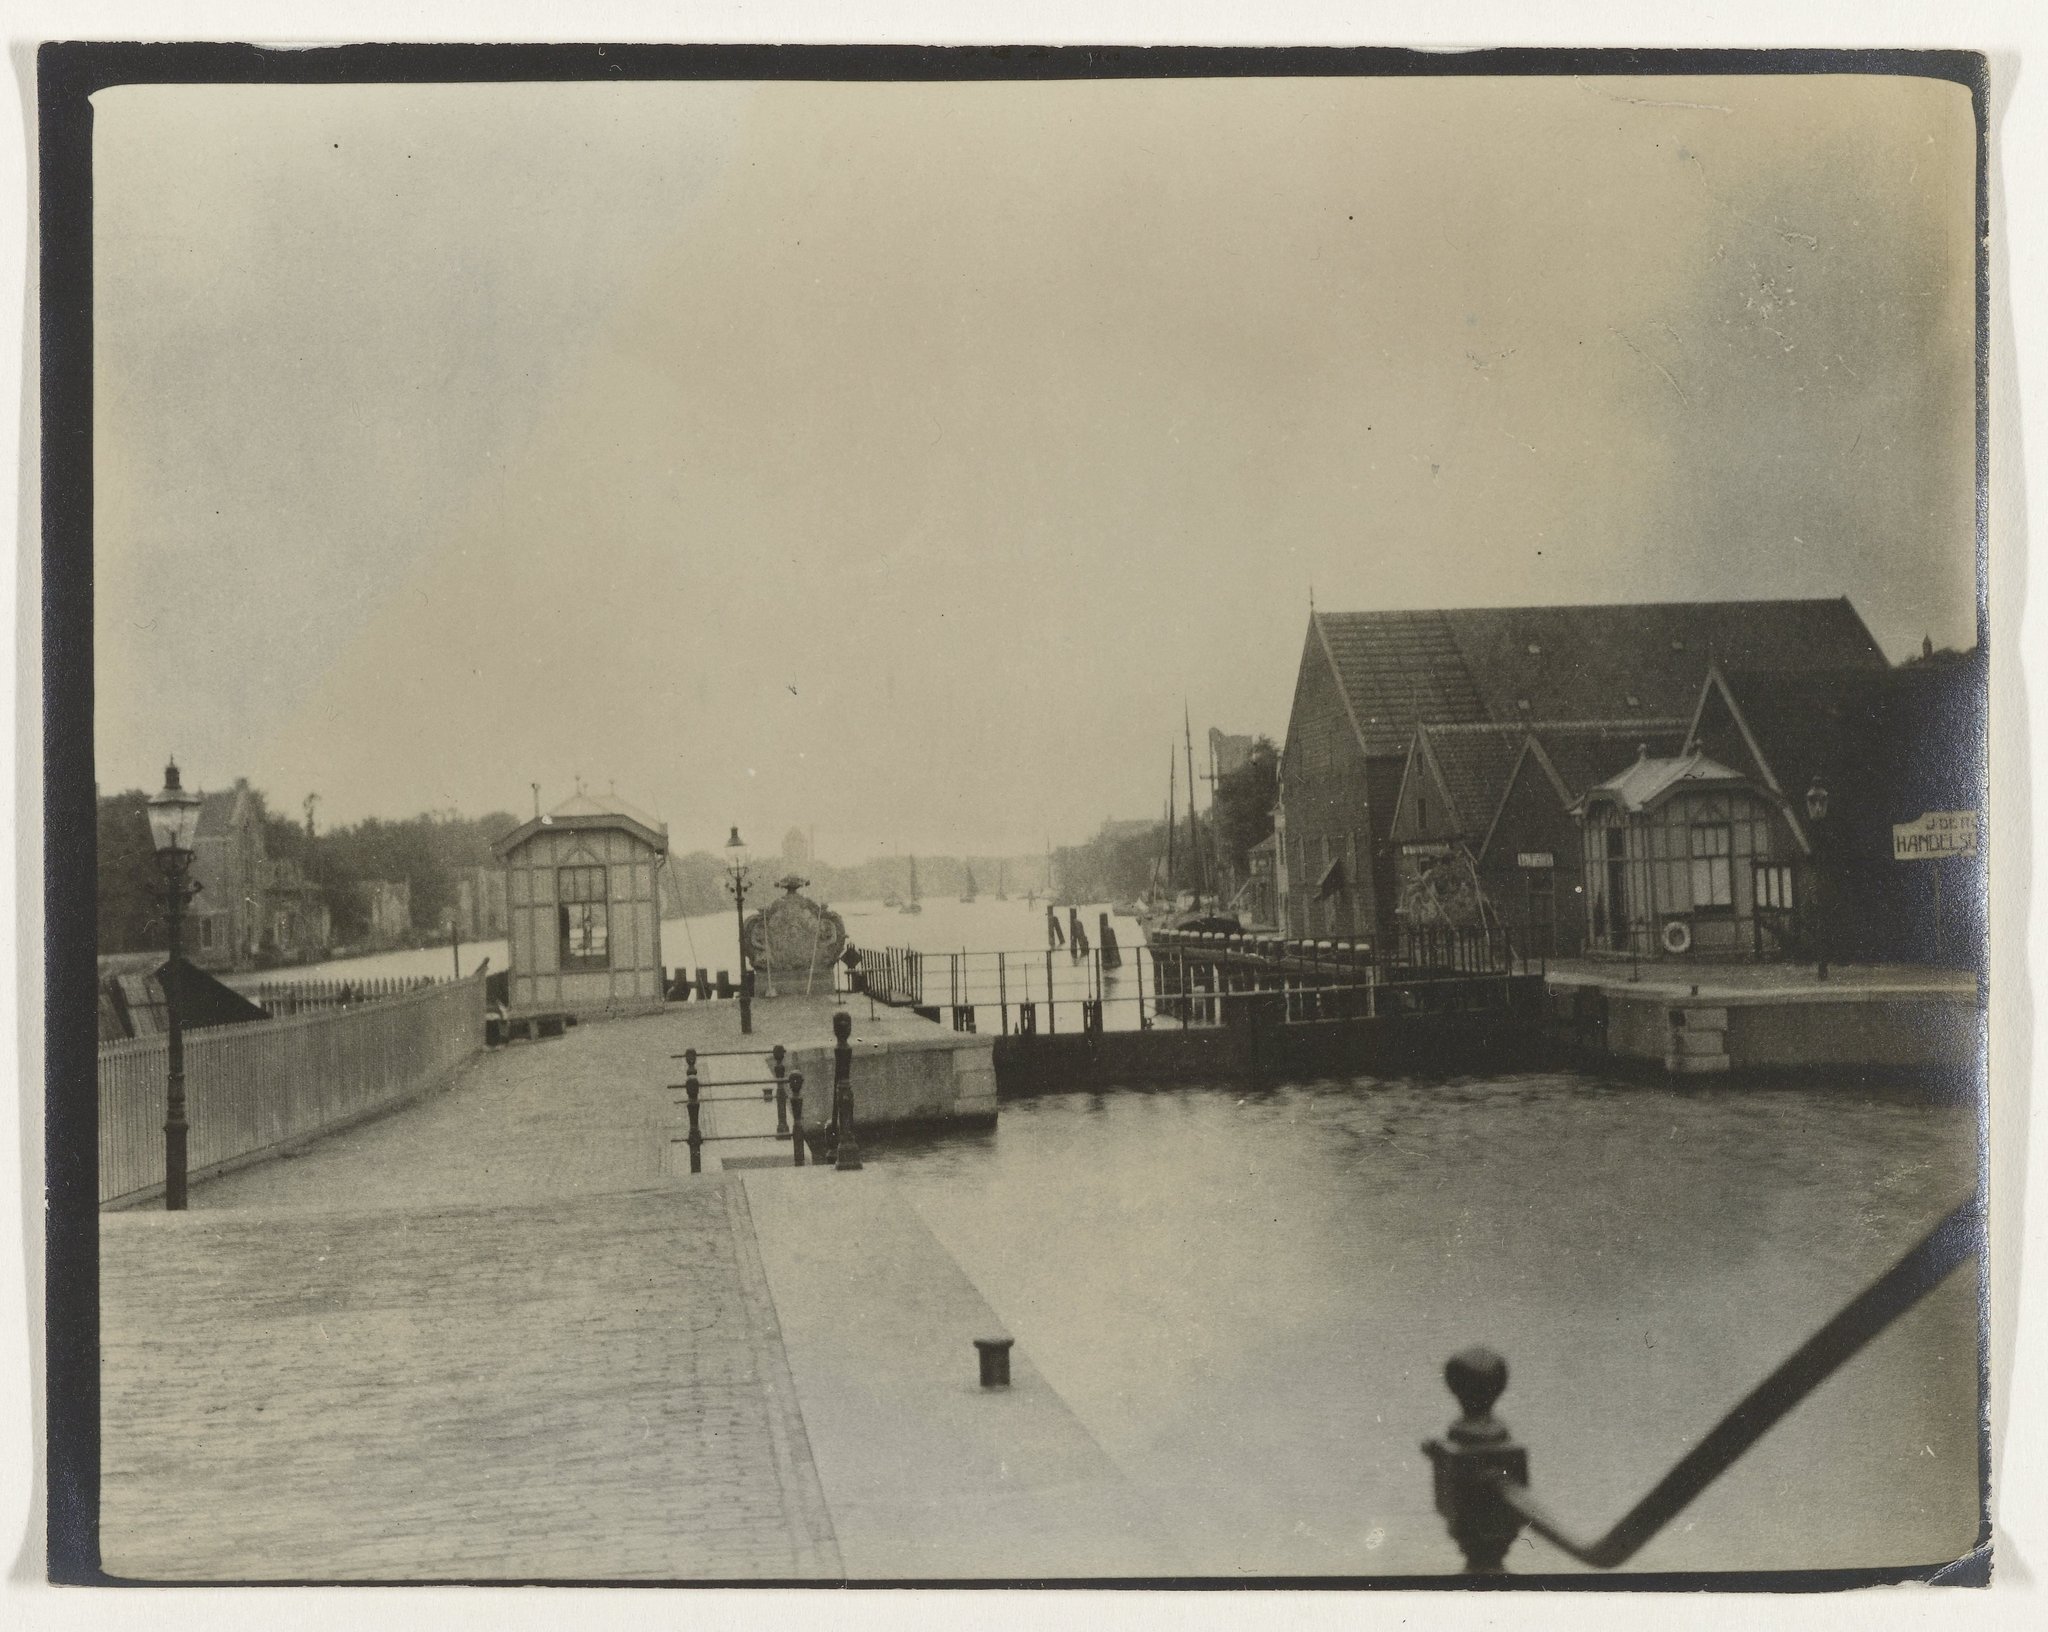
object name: photograph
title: Gezicht op de Wilhelminasluis in Zaandam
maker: Anonymous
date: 1900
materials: paper, photographic support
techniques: gelatin silver print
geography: netherlands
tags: sluice, weir